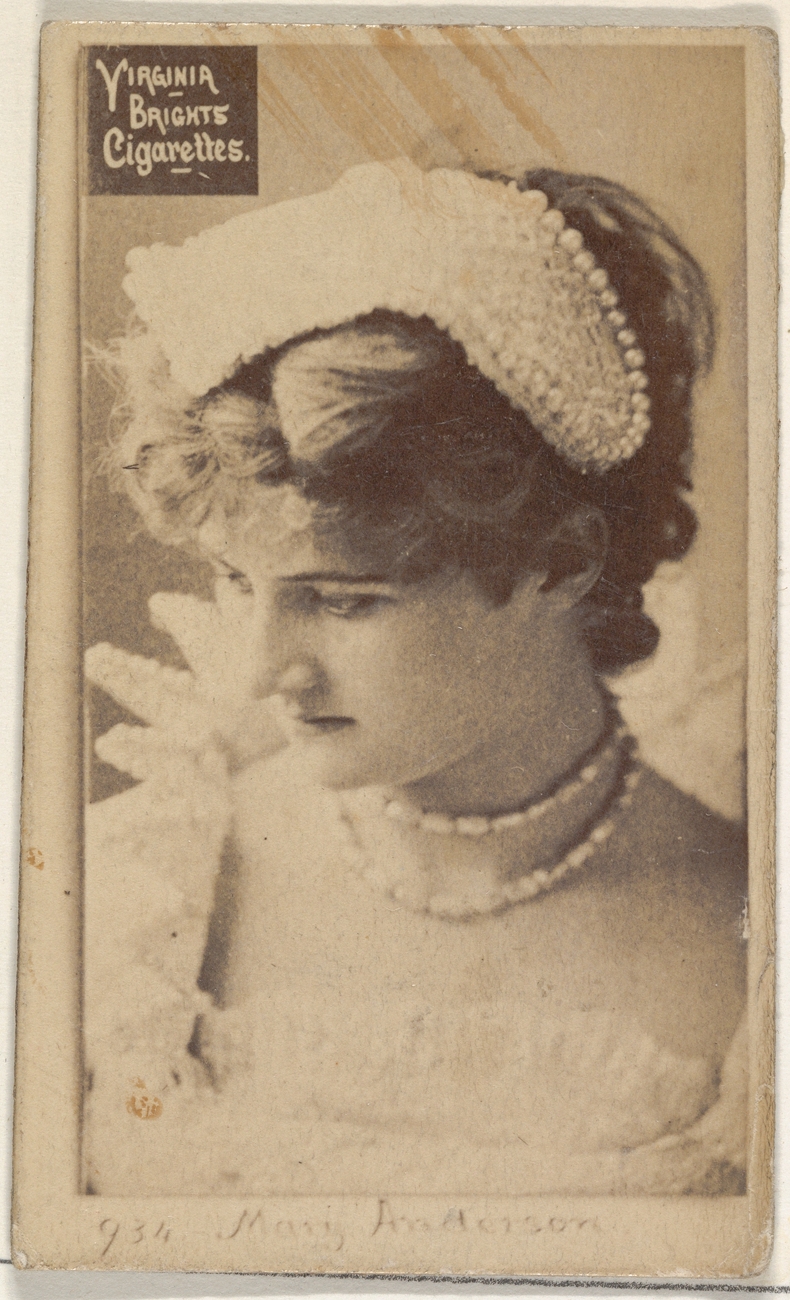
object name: photograph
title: Card 934, Mary Anderson, from the Actors and Actresses series (N45, Type 2) for Virginia Brights Cigarettes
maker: allen & ginter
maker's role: publisher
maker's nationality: american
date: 1888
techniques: albumen silver print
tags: portraits,women,actresses